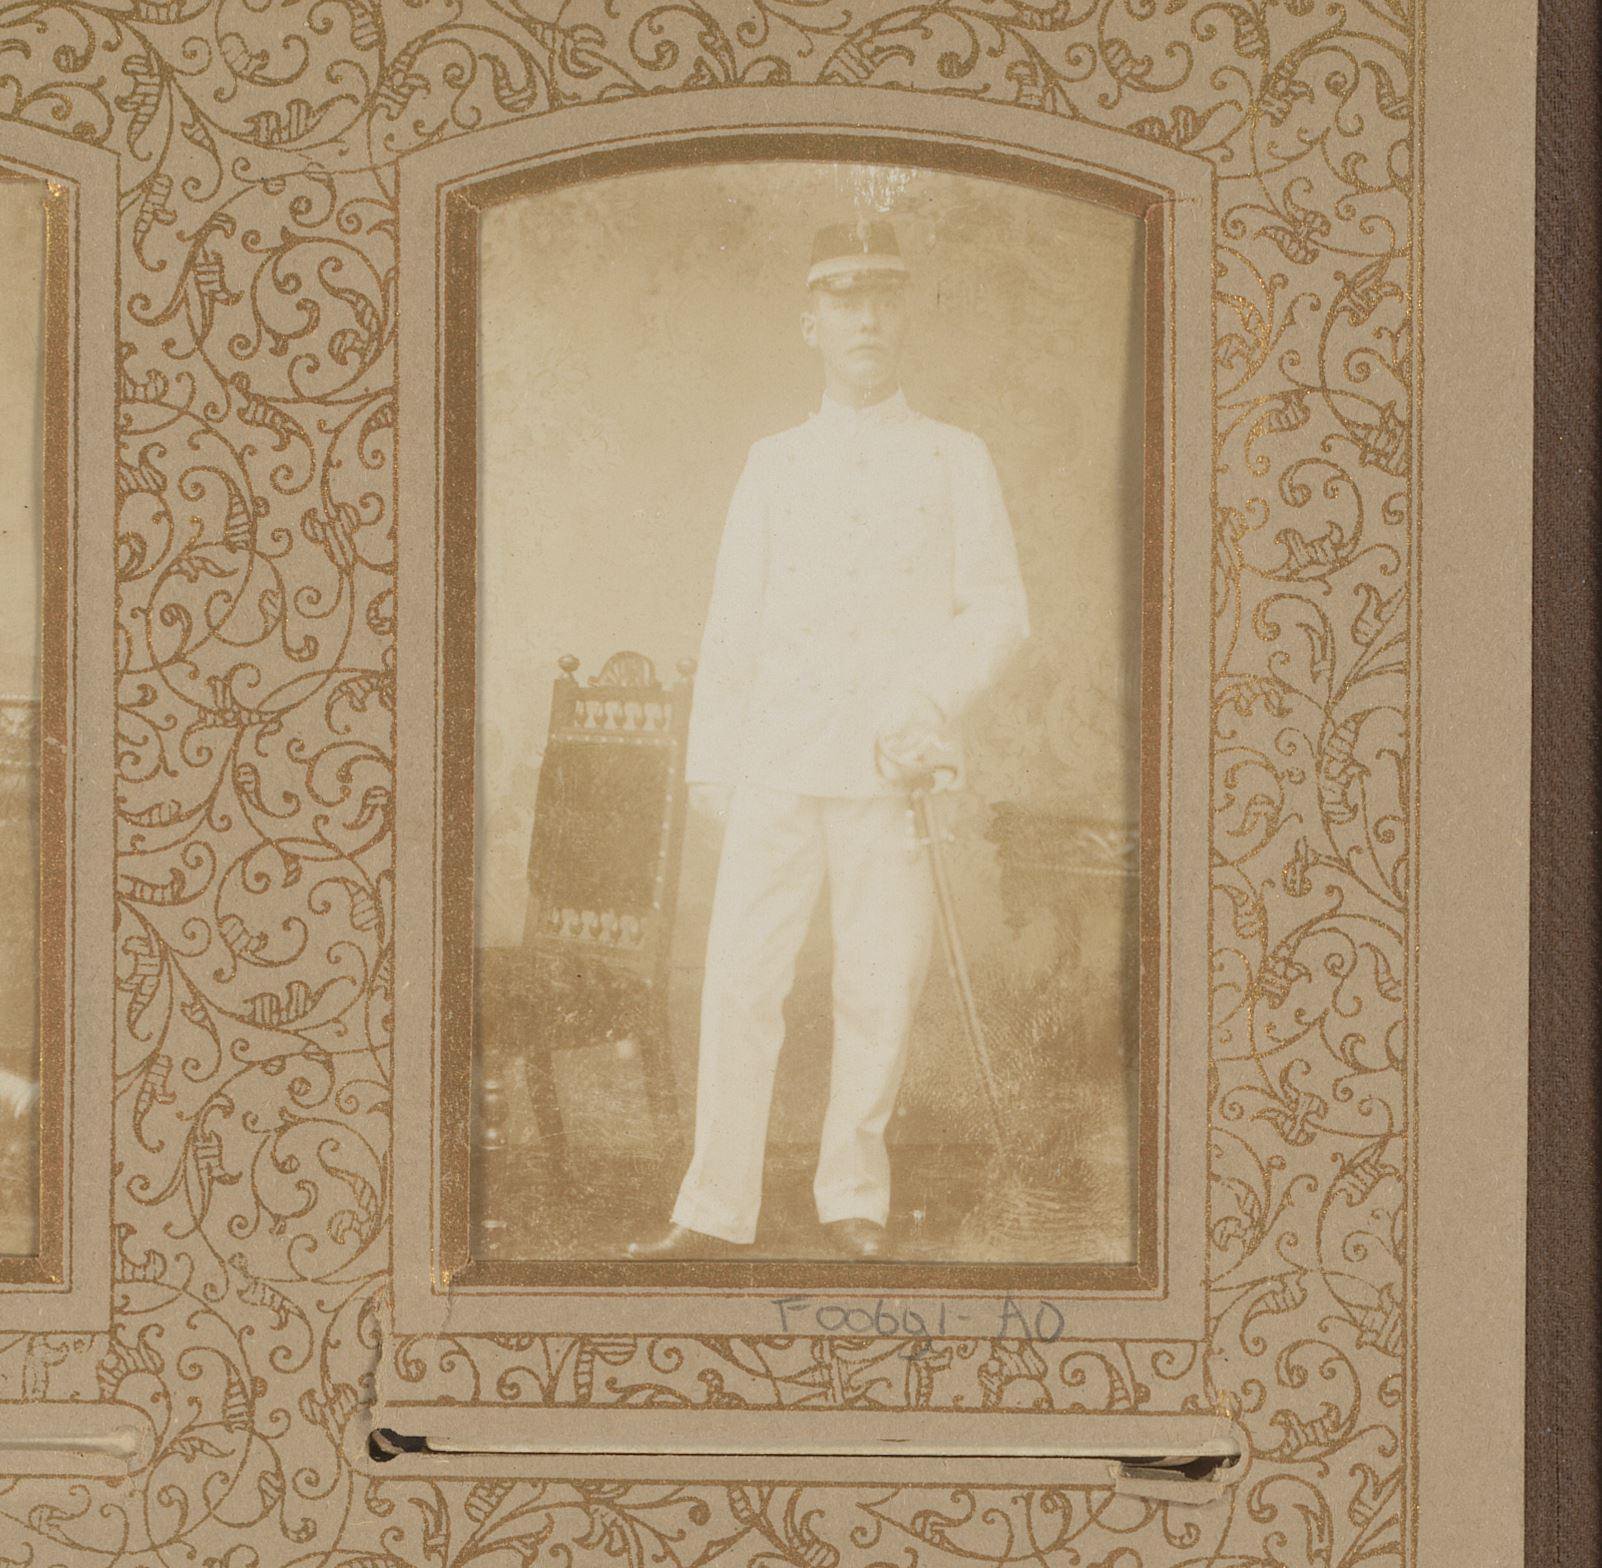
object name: carte de visite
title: Portret van een man in wit uniform met sabel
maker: j.w. wentzel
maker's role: fotograaf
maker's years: 1855-1930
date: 1890-1898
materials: cardboard, photographic support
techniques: collodion silver print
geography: amersfoort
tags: historical persons, hacking and thrusting weapons: sword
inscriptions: inscription: ‘J.W. Wentzel/ Amersfoort/ Langestraat F.12’